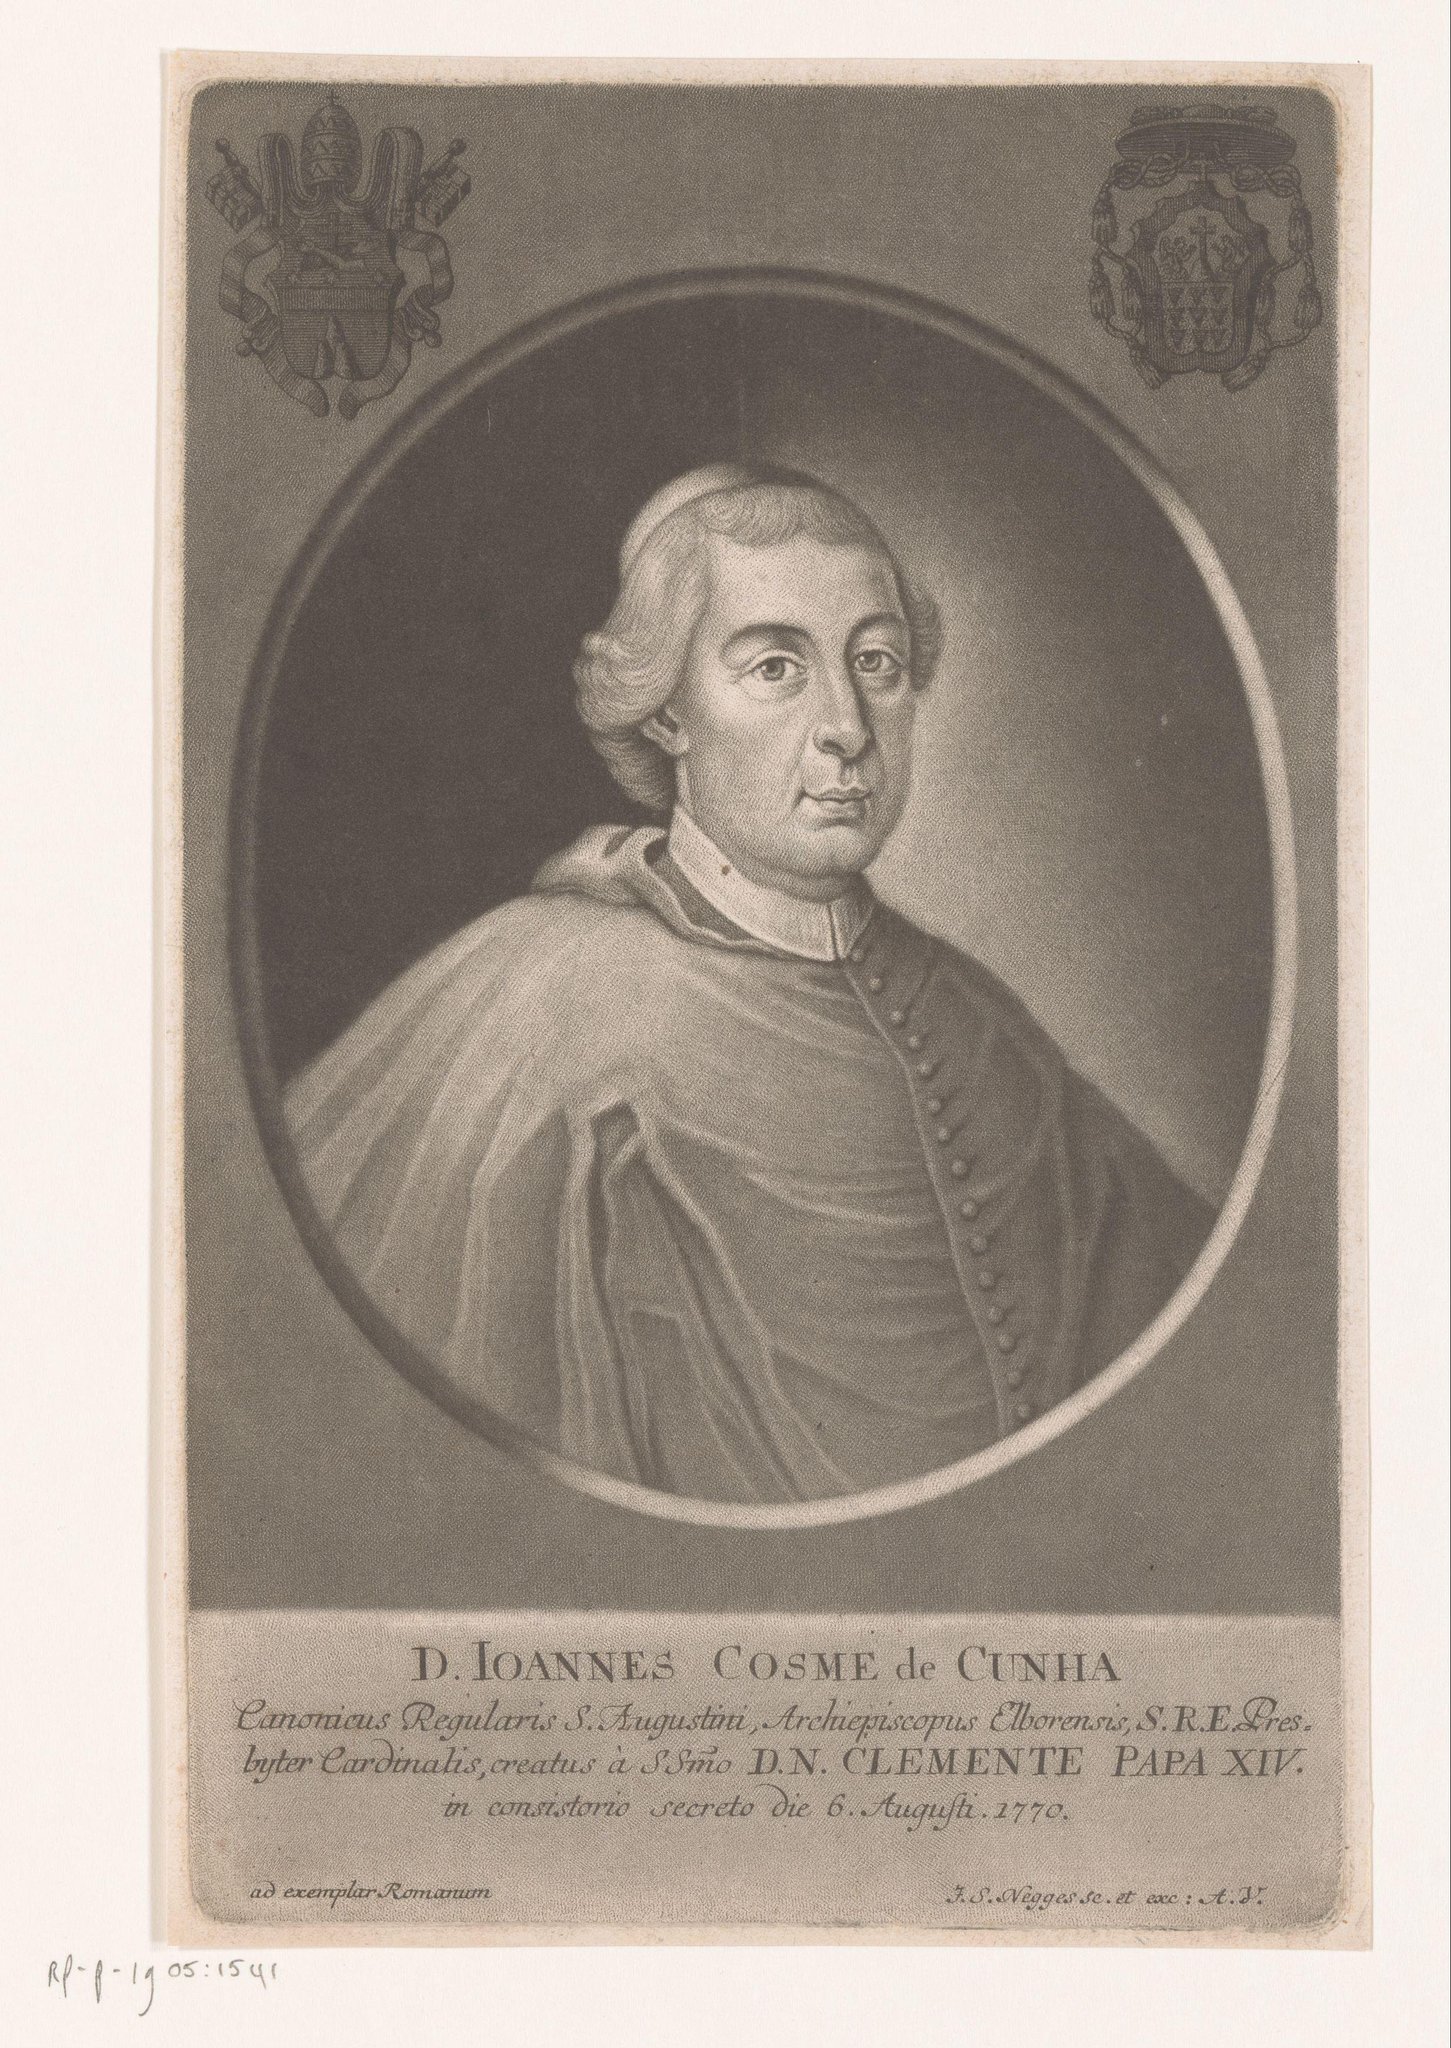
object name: print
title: Portret van João Cosme da Cunha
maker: johann simon negges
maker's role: print maker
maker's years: 1726-1792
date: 1736-1792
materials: paper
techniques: mezzotint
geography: augsburg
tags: historical persons, armorial bearing, heraldry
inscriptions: collector's mark: Lugt 2228